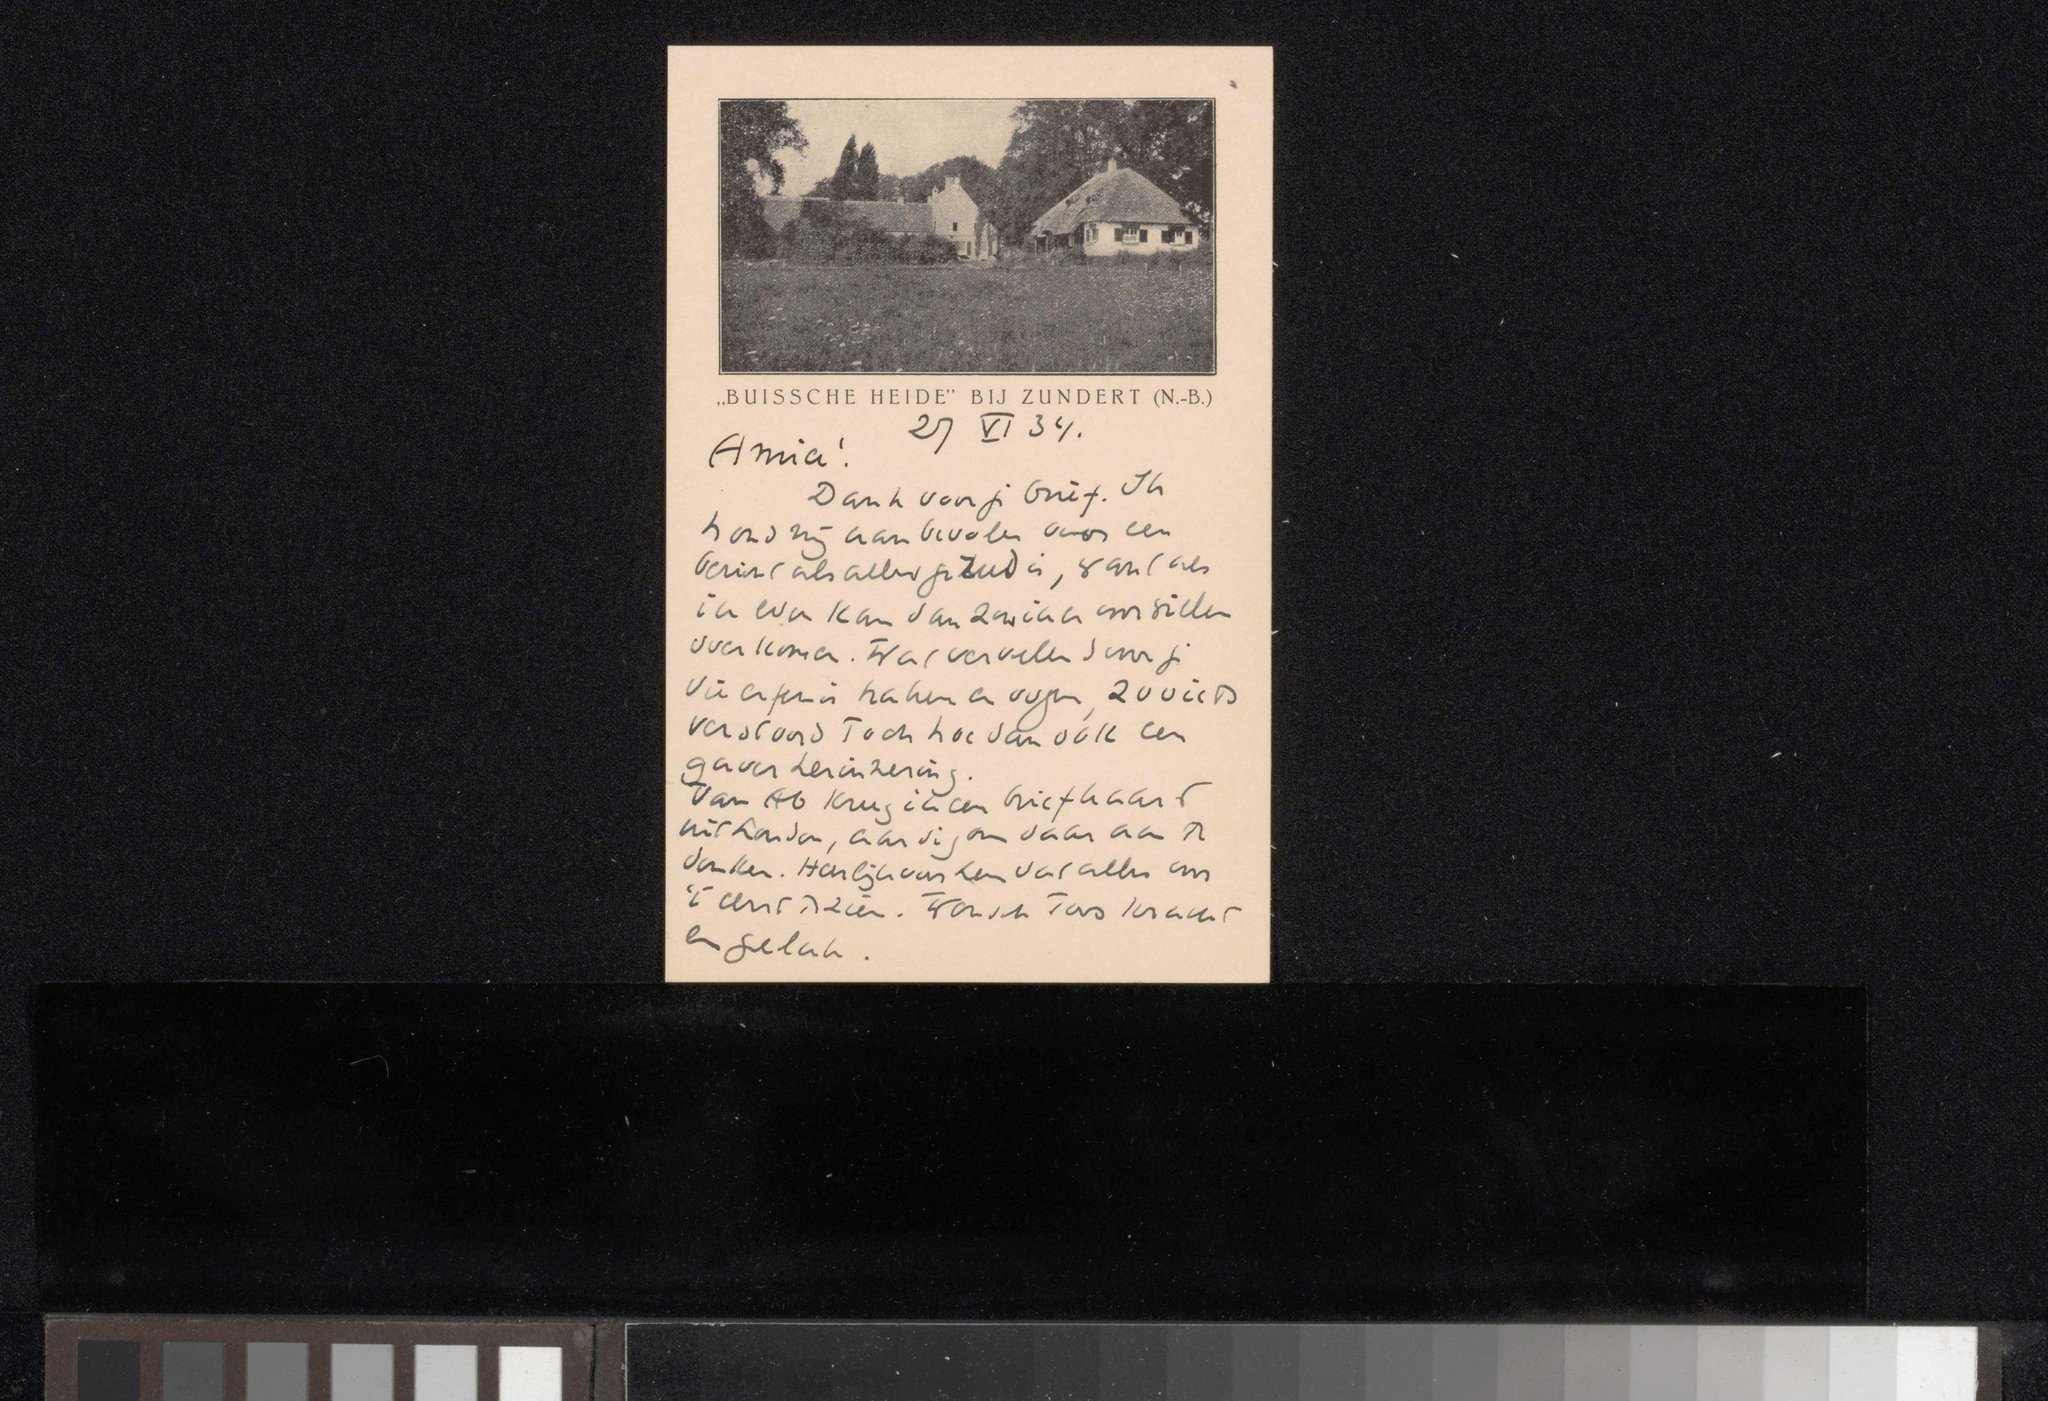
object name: ansichtkaart, prentbriefkaart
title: Prentbriefkaart aan Willem Bogtman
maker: richard nicolaüs roland holst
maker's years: 1868-1938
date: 1934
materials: cardboard, ink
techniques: pen, writing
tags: draughtsman, louis boermeester, ab bogtman, print maker, toos bogtman, haarlem, willem bogtman, applied arts, arts and crafts; industrial design, workshop, studio of the artist (in general), london